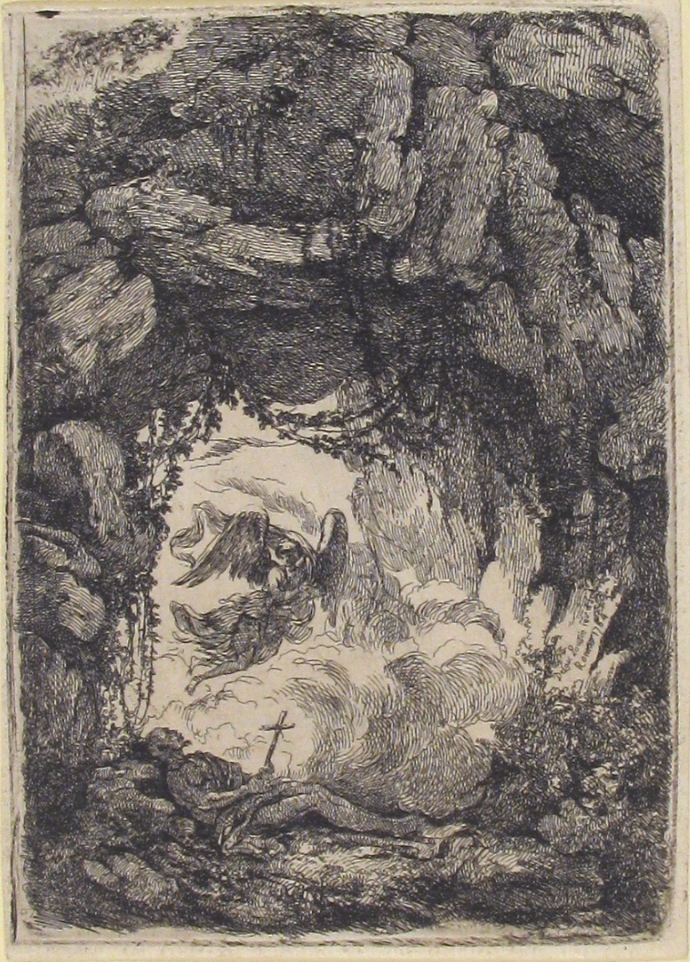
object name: print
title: Hermit and Angel in a Landscape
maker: etienne de lavallée-poussin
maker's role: artist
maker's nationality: french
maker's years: 1733-1793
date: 1701-1800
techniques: etching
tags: men,landscapes,angels